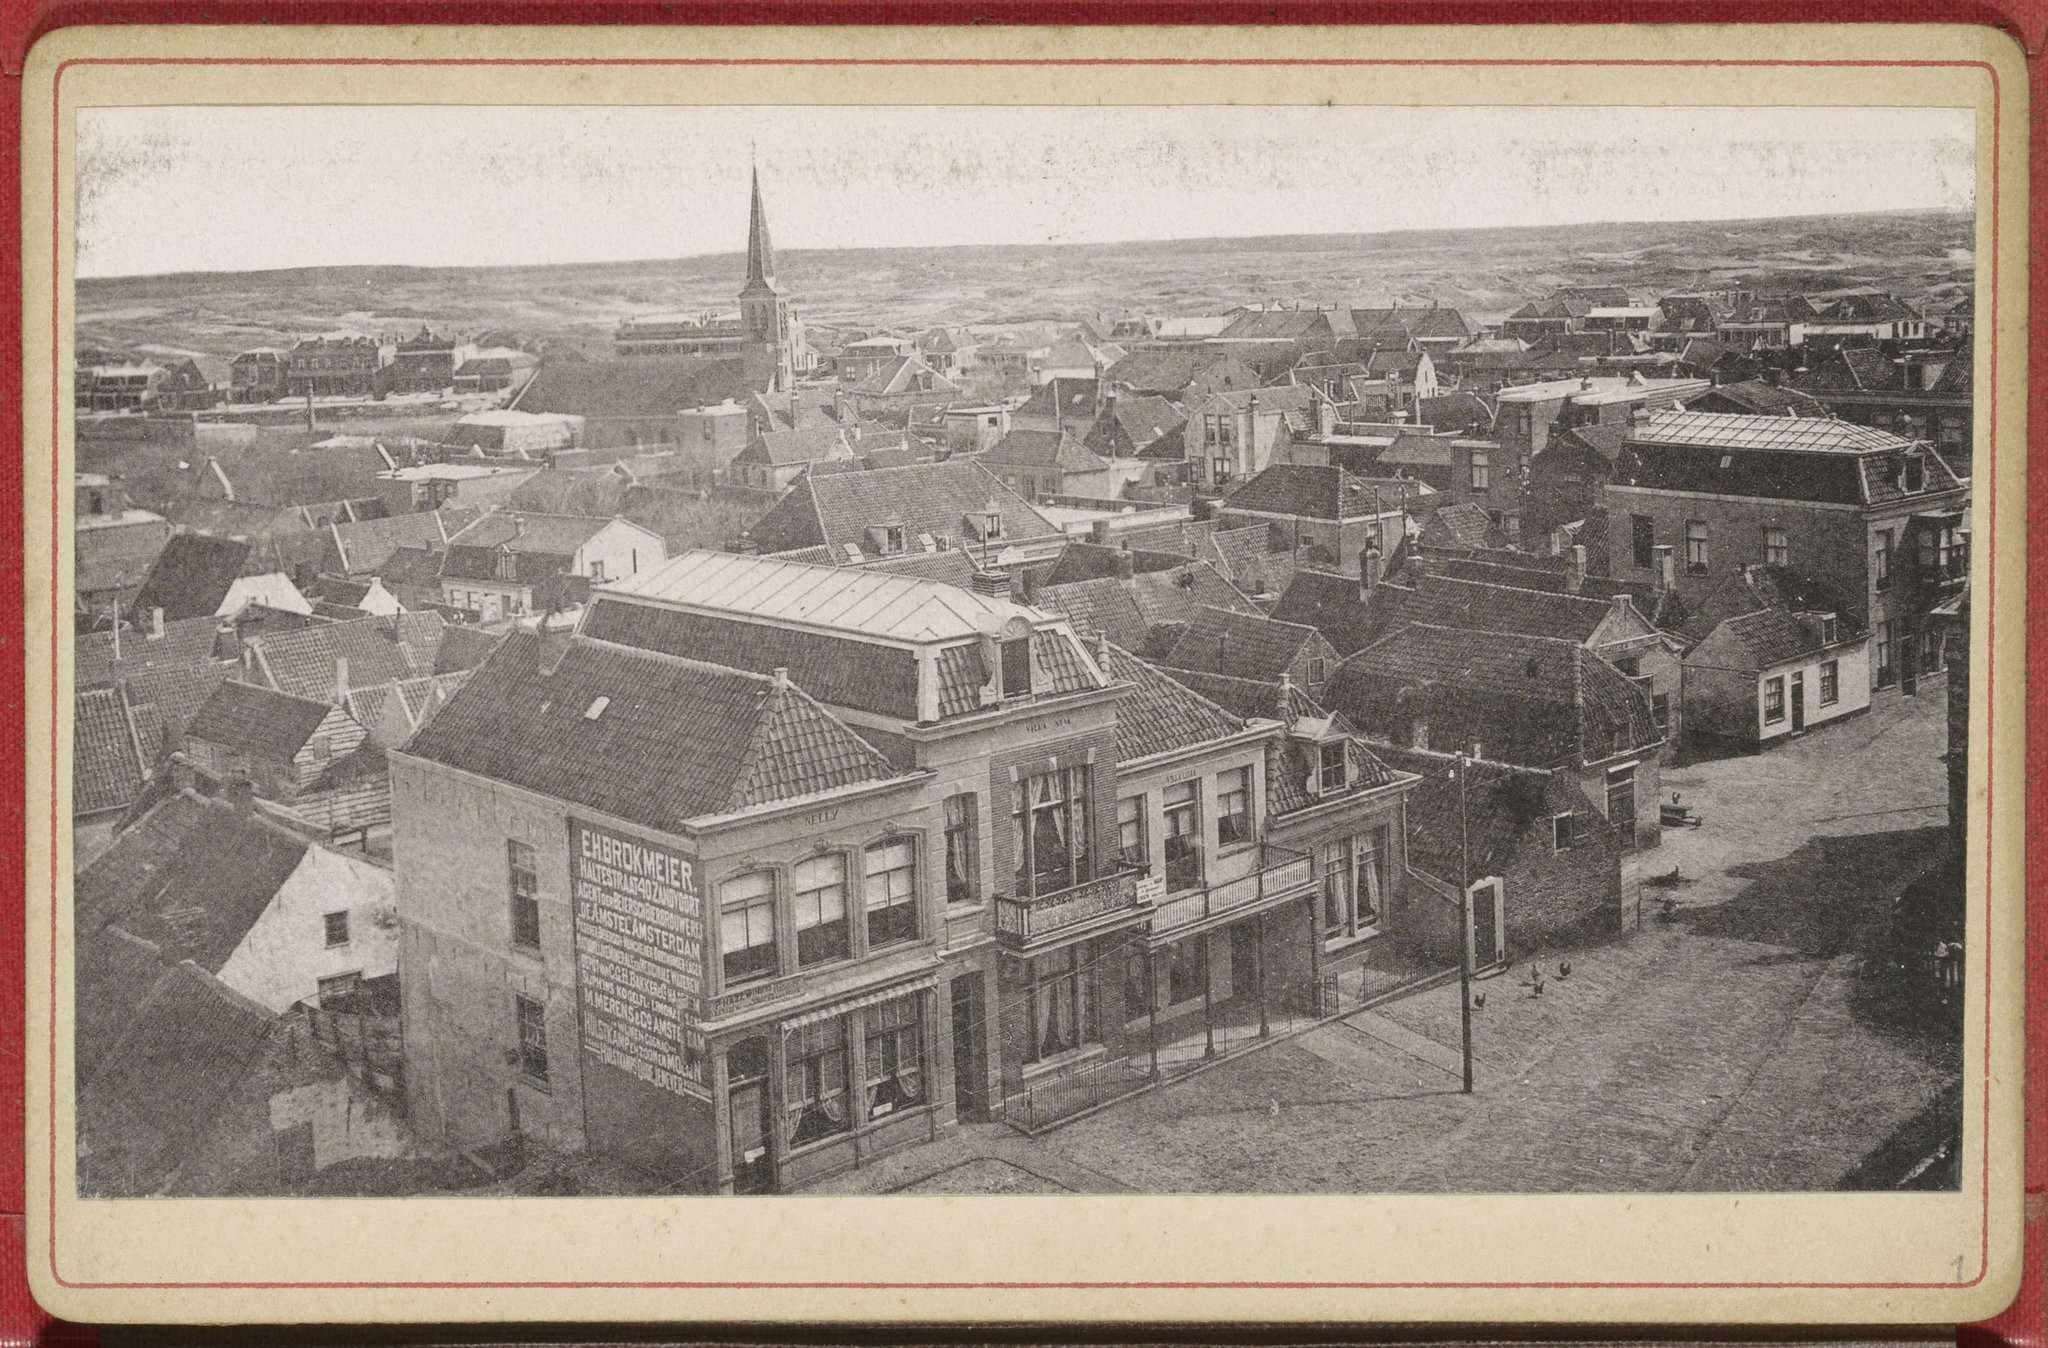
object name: photomechanical print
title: Gezicht op Zandvoort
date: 1890-1900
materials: paper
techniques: photograph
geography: zandvoort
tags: prospect of village, silhouette of village, advertising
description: Onderdeel van Leporelloalbum met opnames van Zandvoort.